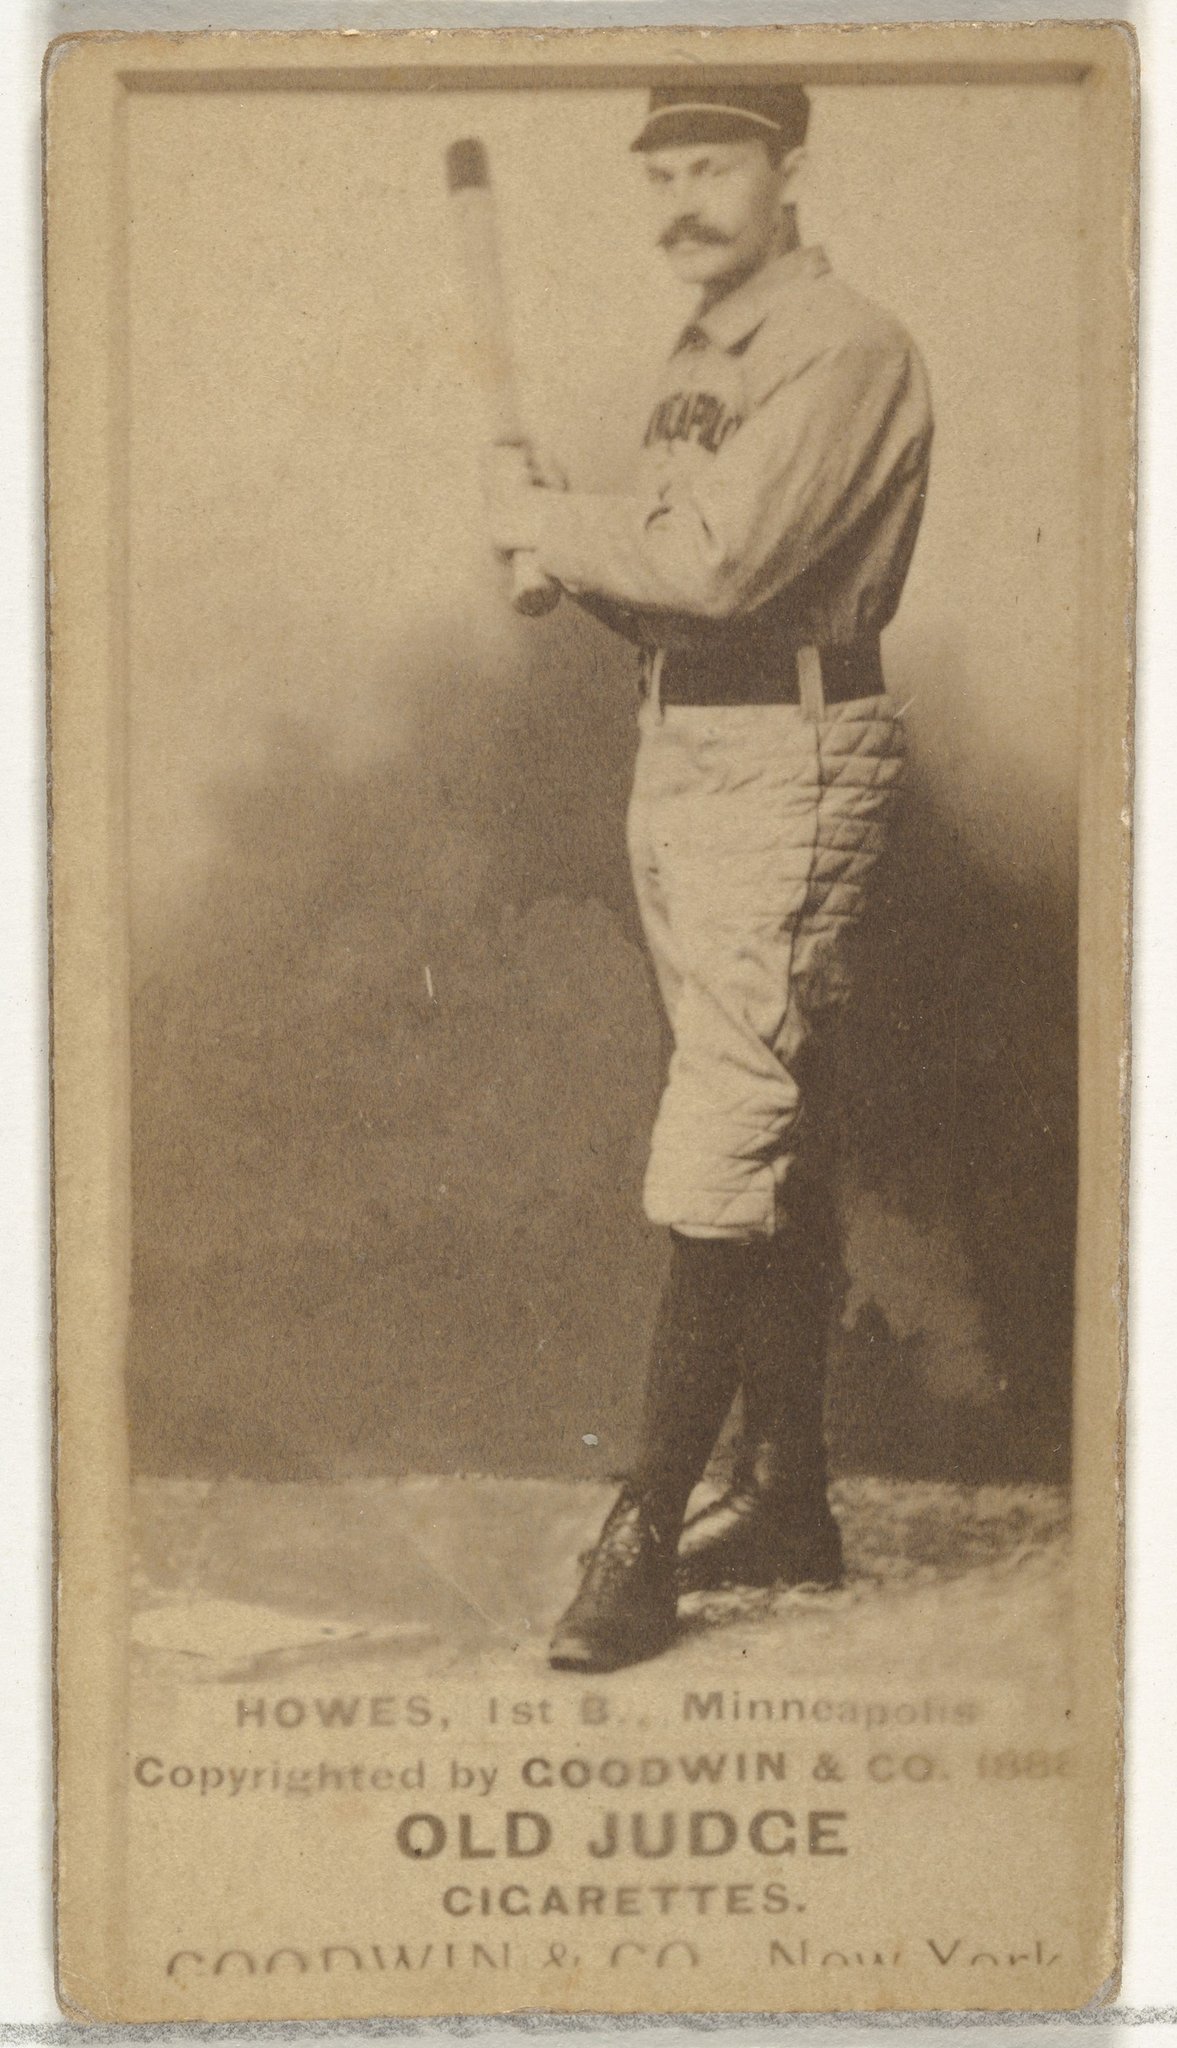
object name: baseball card, photograph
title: William Hildreth "Bill" Hawes, 1st Base, Minneapolis, from the Old Judge series (N172) for Old Judge Cigarettes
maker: goodwin & company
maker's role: publisher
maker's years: 1850-1950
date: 1888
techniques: albumen silver print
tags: men,portraits,baseball,athletes